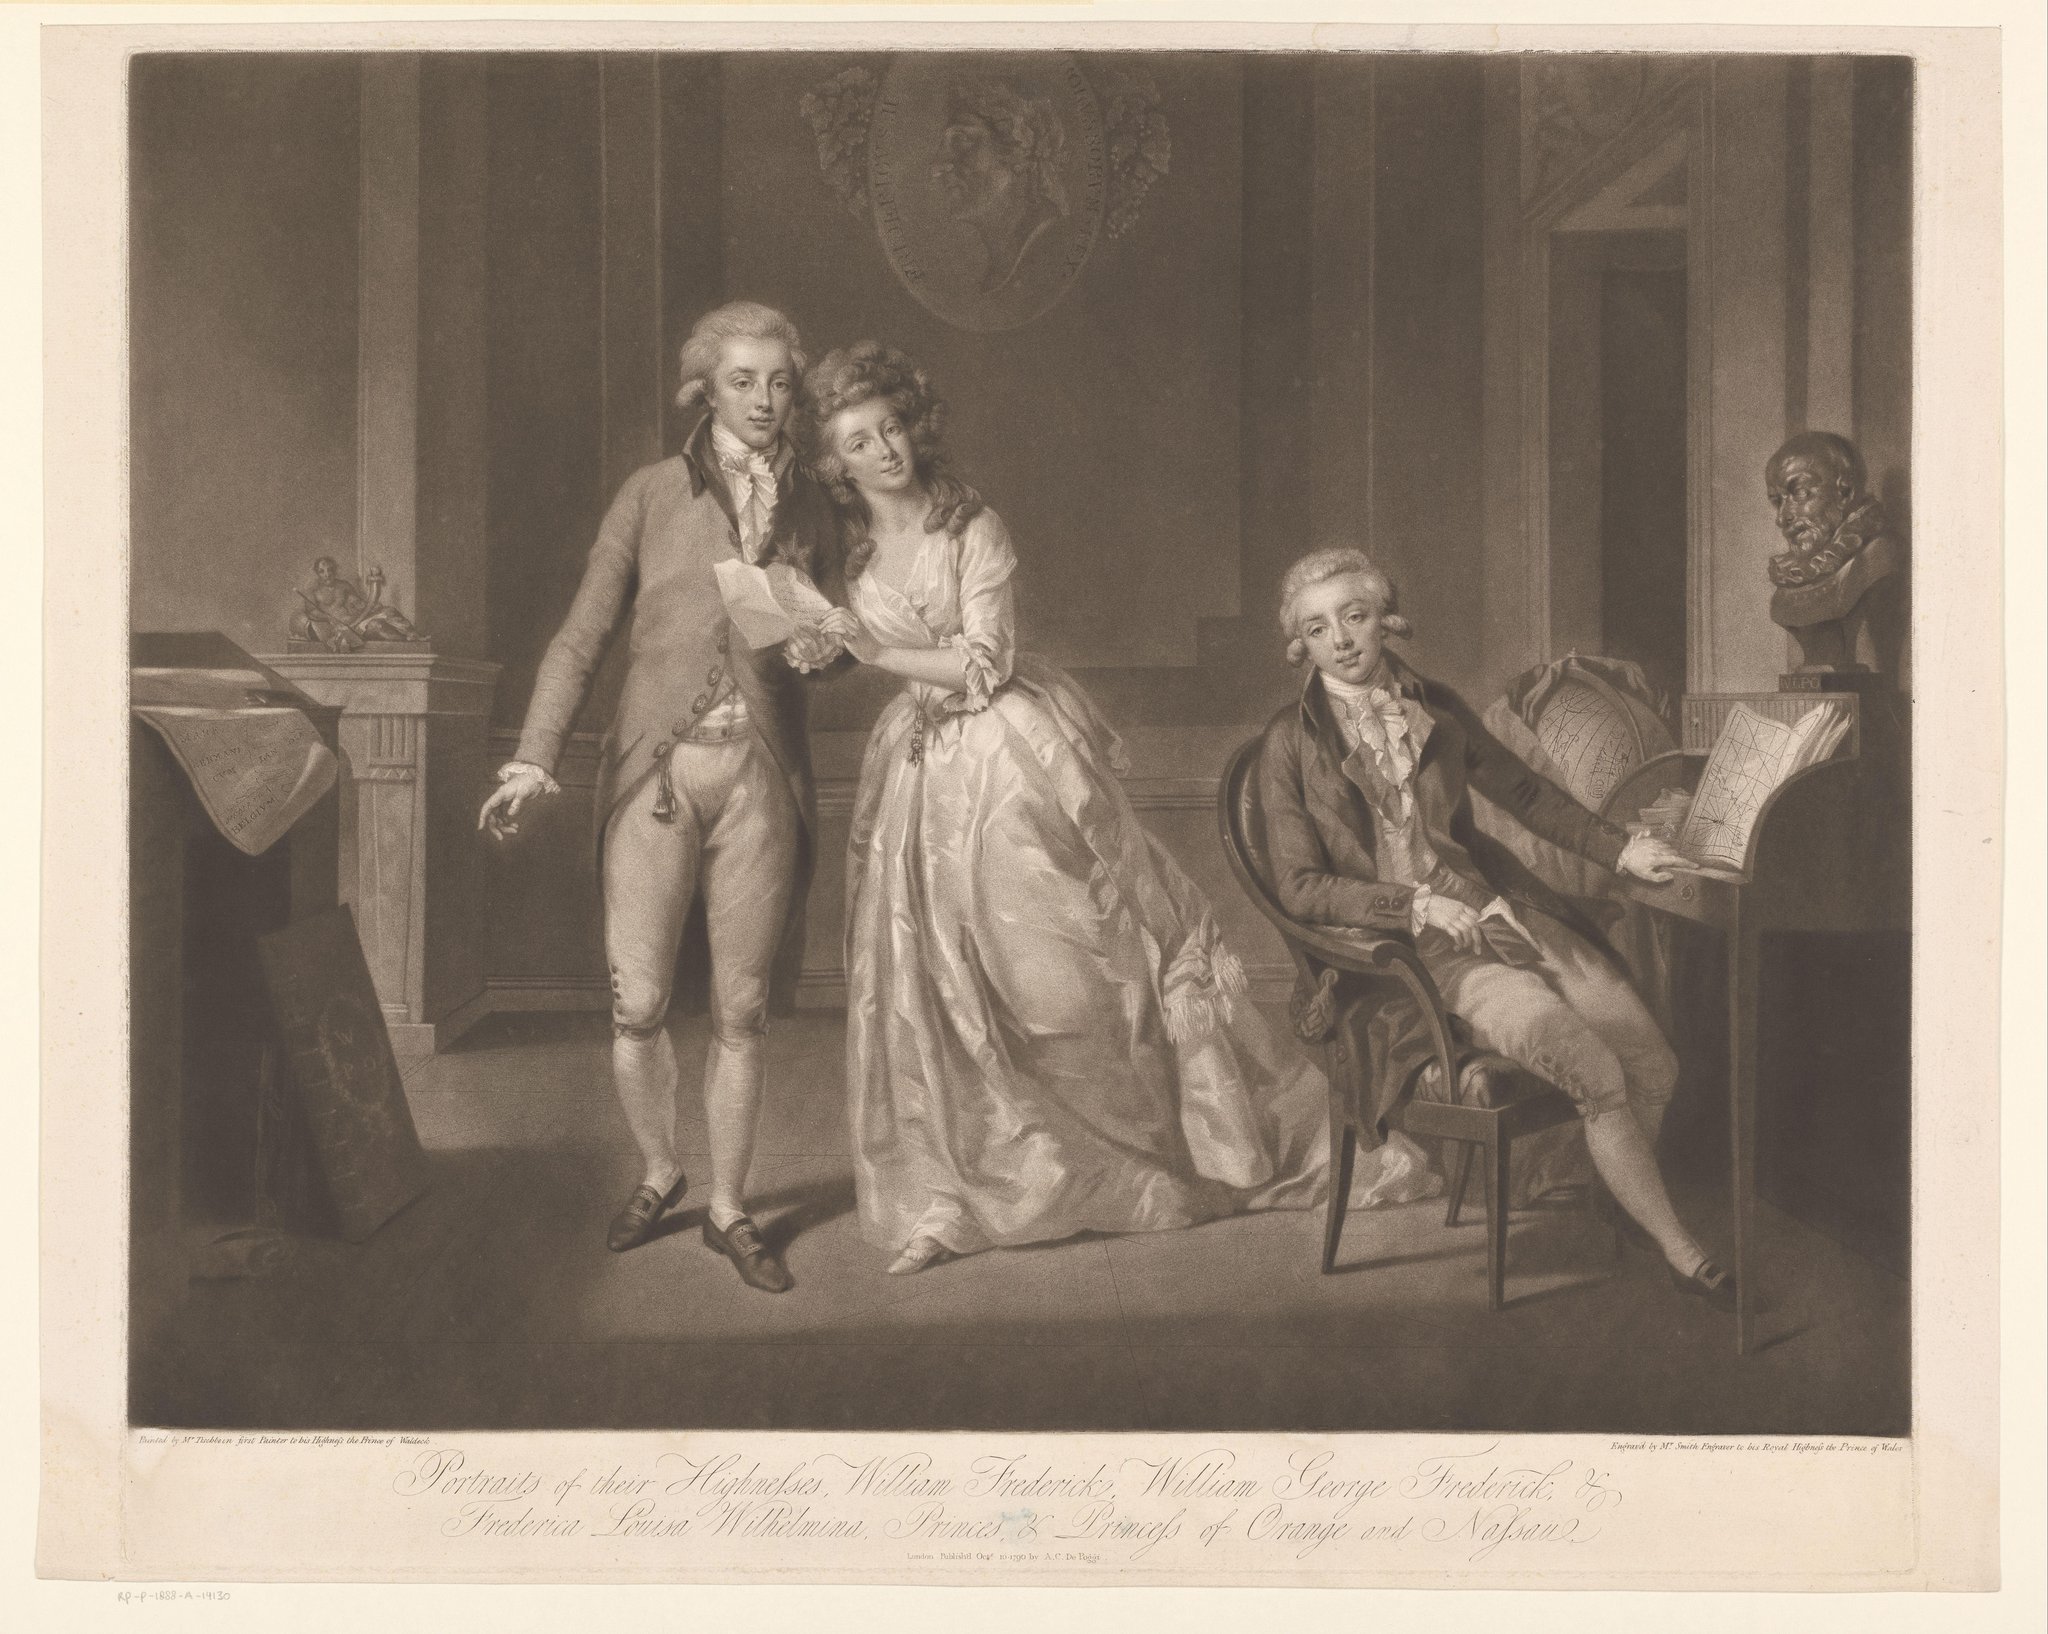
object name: print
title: Portret van de kinderen van Willem V en Wilhelmina van Pruisen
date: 1710-1790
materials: paper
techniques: etching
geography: london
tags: the hague, berlin, william i of the netherlands, delft, william i (prince of orange), frederick ii (king of prussia), amsterdam, louise (prinses van oranje-nassau), willem george frederik (prins van oranje-nassau), writing-table, writing-desk, historical person (with name) - historical person (with name) portrayed in a group, in a group-portrait, letter, envelope, brothers or sisters (second degree family relationships)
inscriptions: collector's mark: Lugt 2228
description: Louise en Willem staan naast elkaar en houden een brief vast. Frederik zit aan een secretaire, waarop een buste van Willem van Oranje staat. Tegen de achterwand een medaillon met het portret van koning Frederik II van Pruisen.